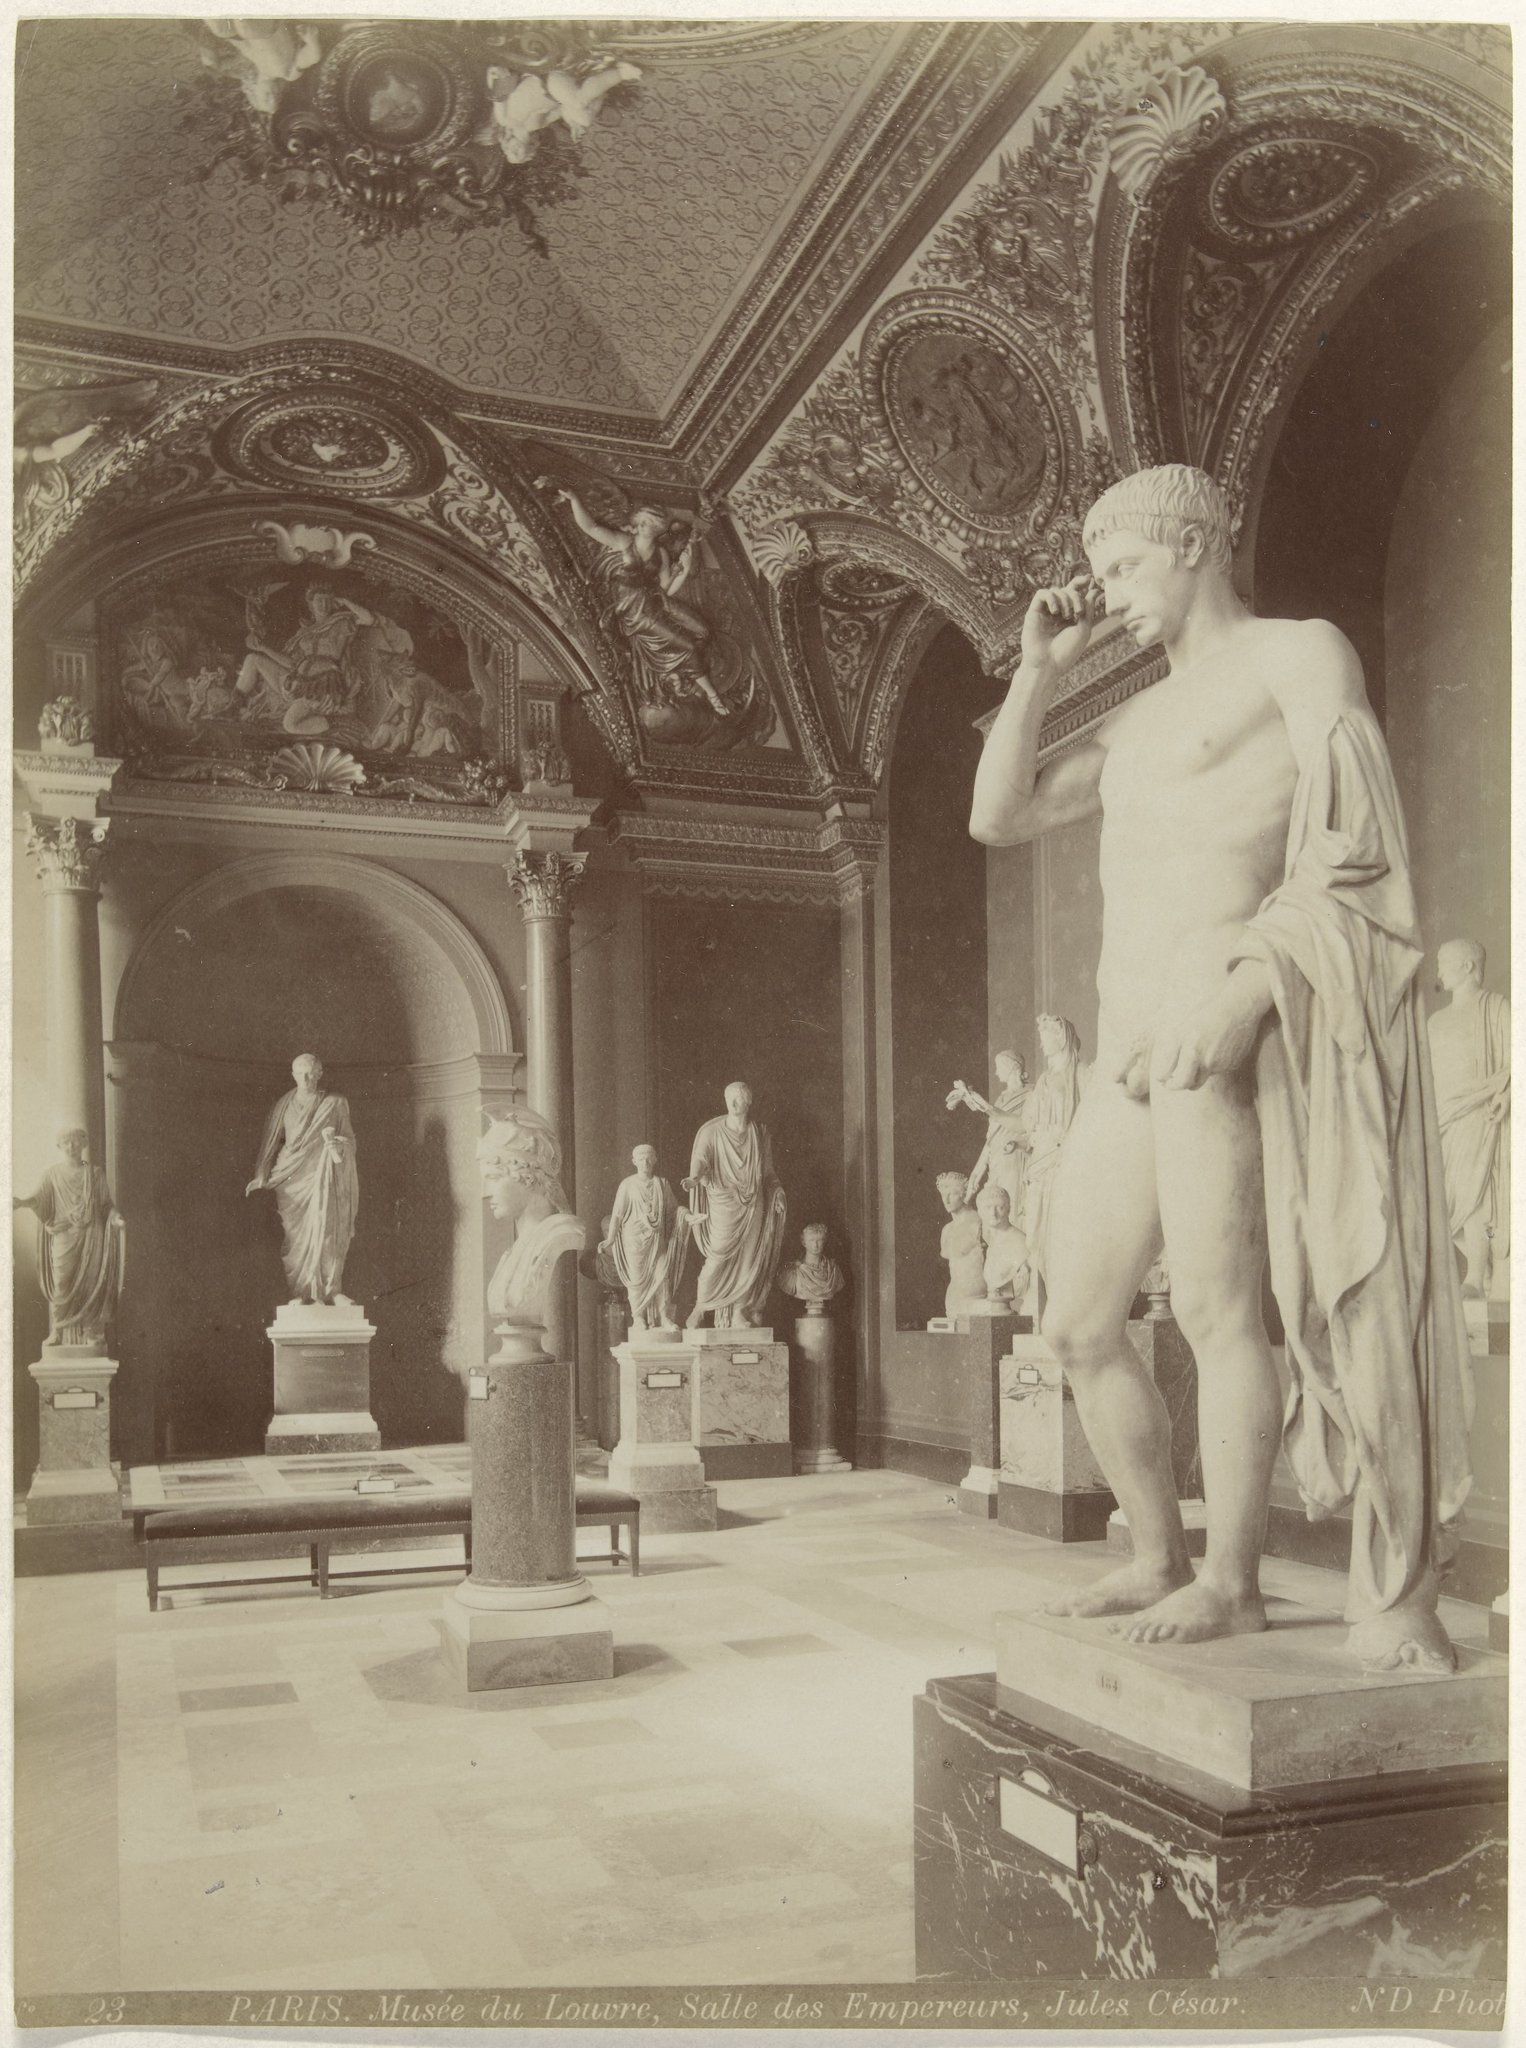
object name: photograph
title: Sculpturen in het Louvre, Parijs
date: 1863-1900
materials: paper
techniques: albumen print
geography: paris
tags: rome, gallery of sculptures, sculpture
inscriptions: inscription: ‘23 Paris. Musée du Louvre, Salle des Empereurs, Jules César ND’, number: ‘14’